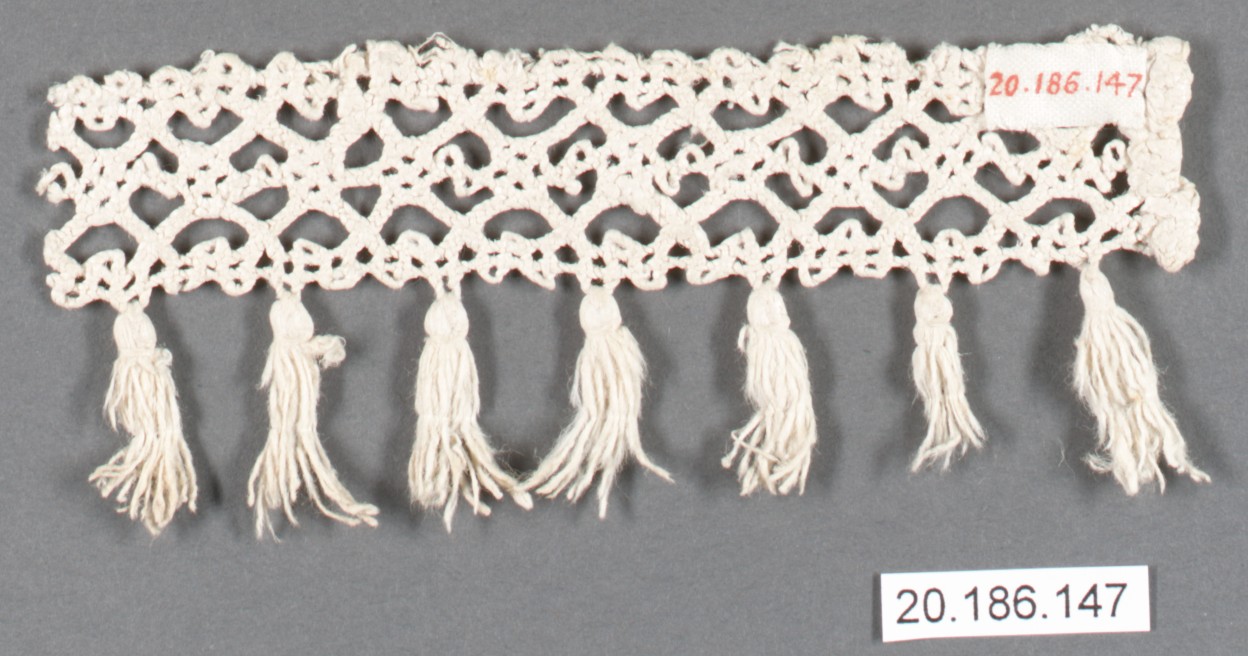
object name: fragment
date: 1501-1600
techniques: lace